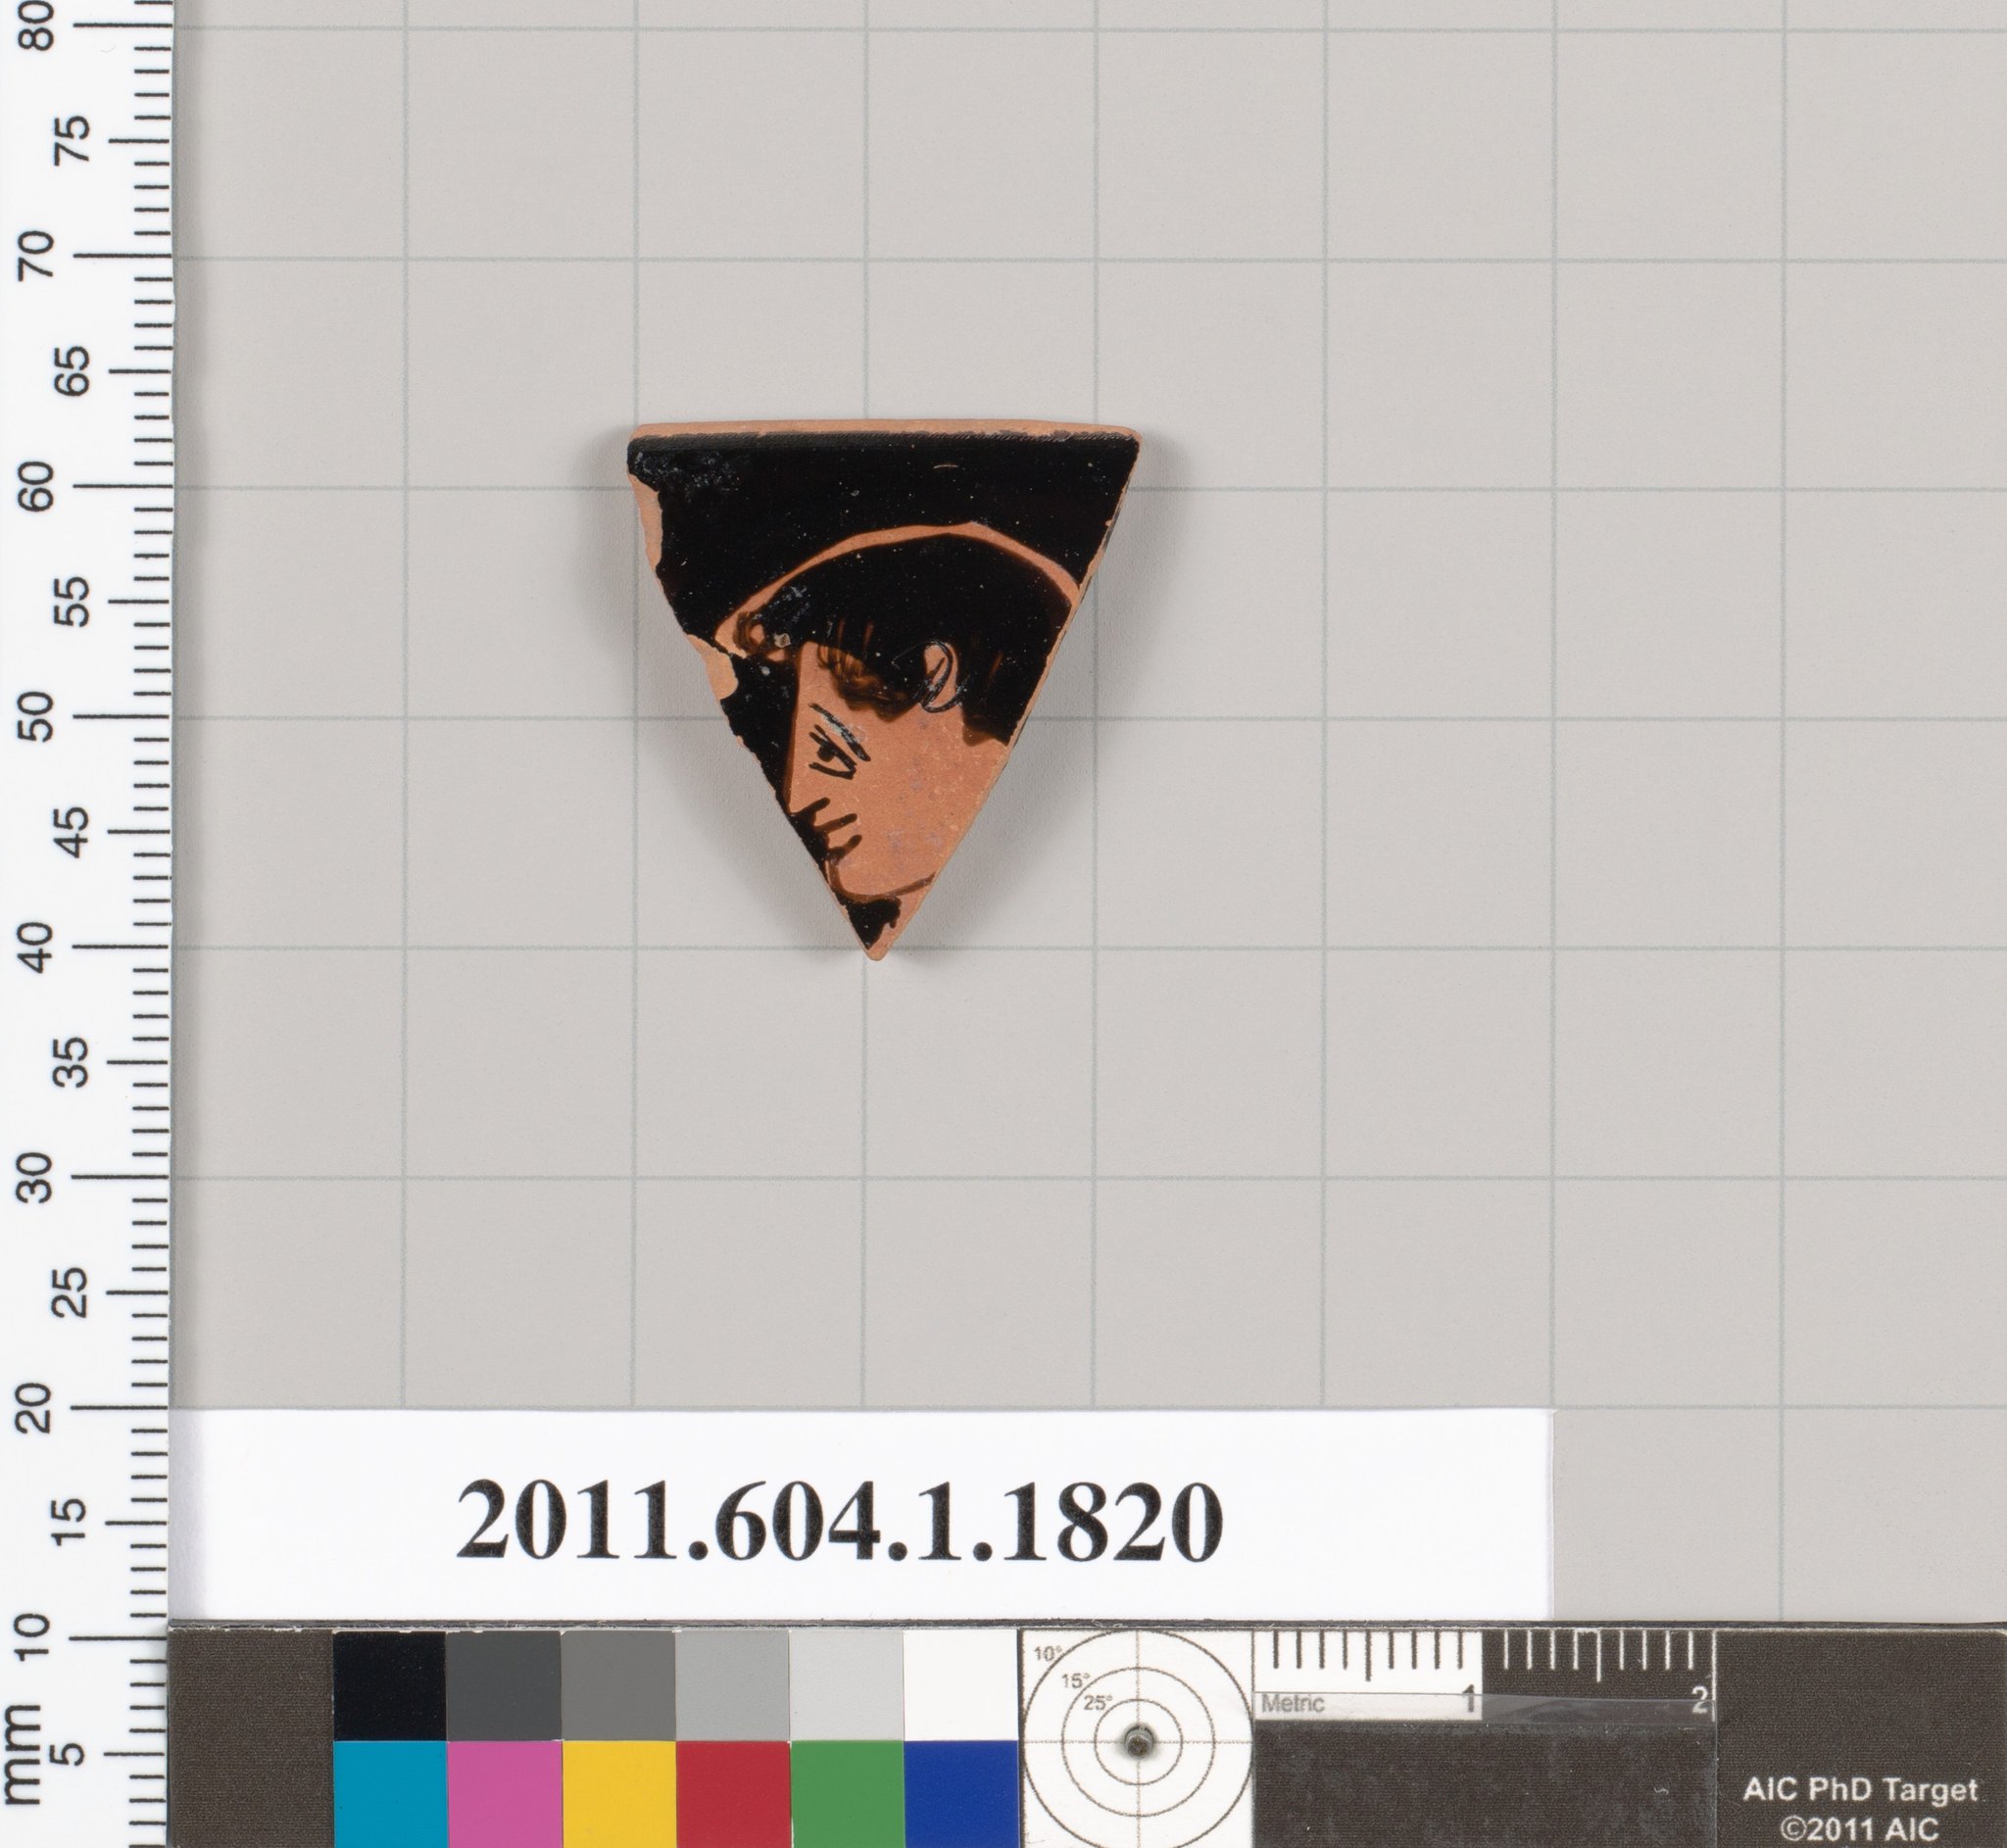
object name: kylix fragment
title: Terracotta rim fragment of a kylix (drinking cup)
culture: greek, attic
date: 467-435 BCE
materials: terracotta